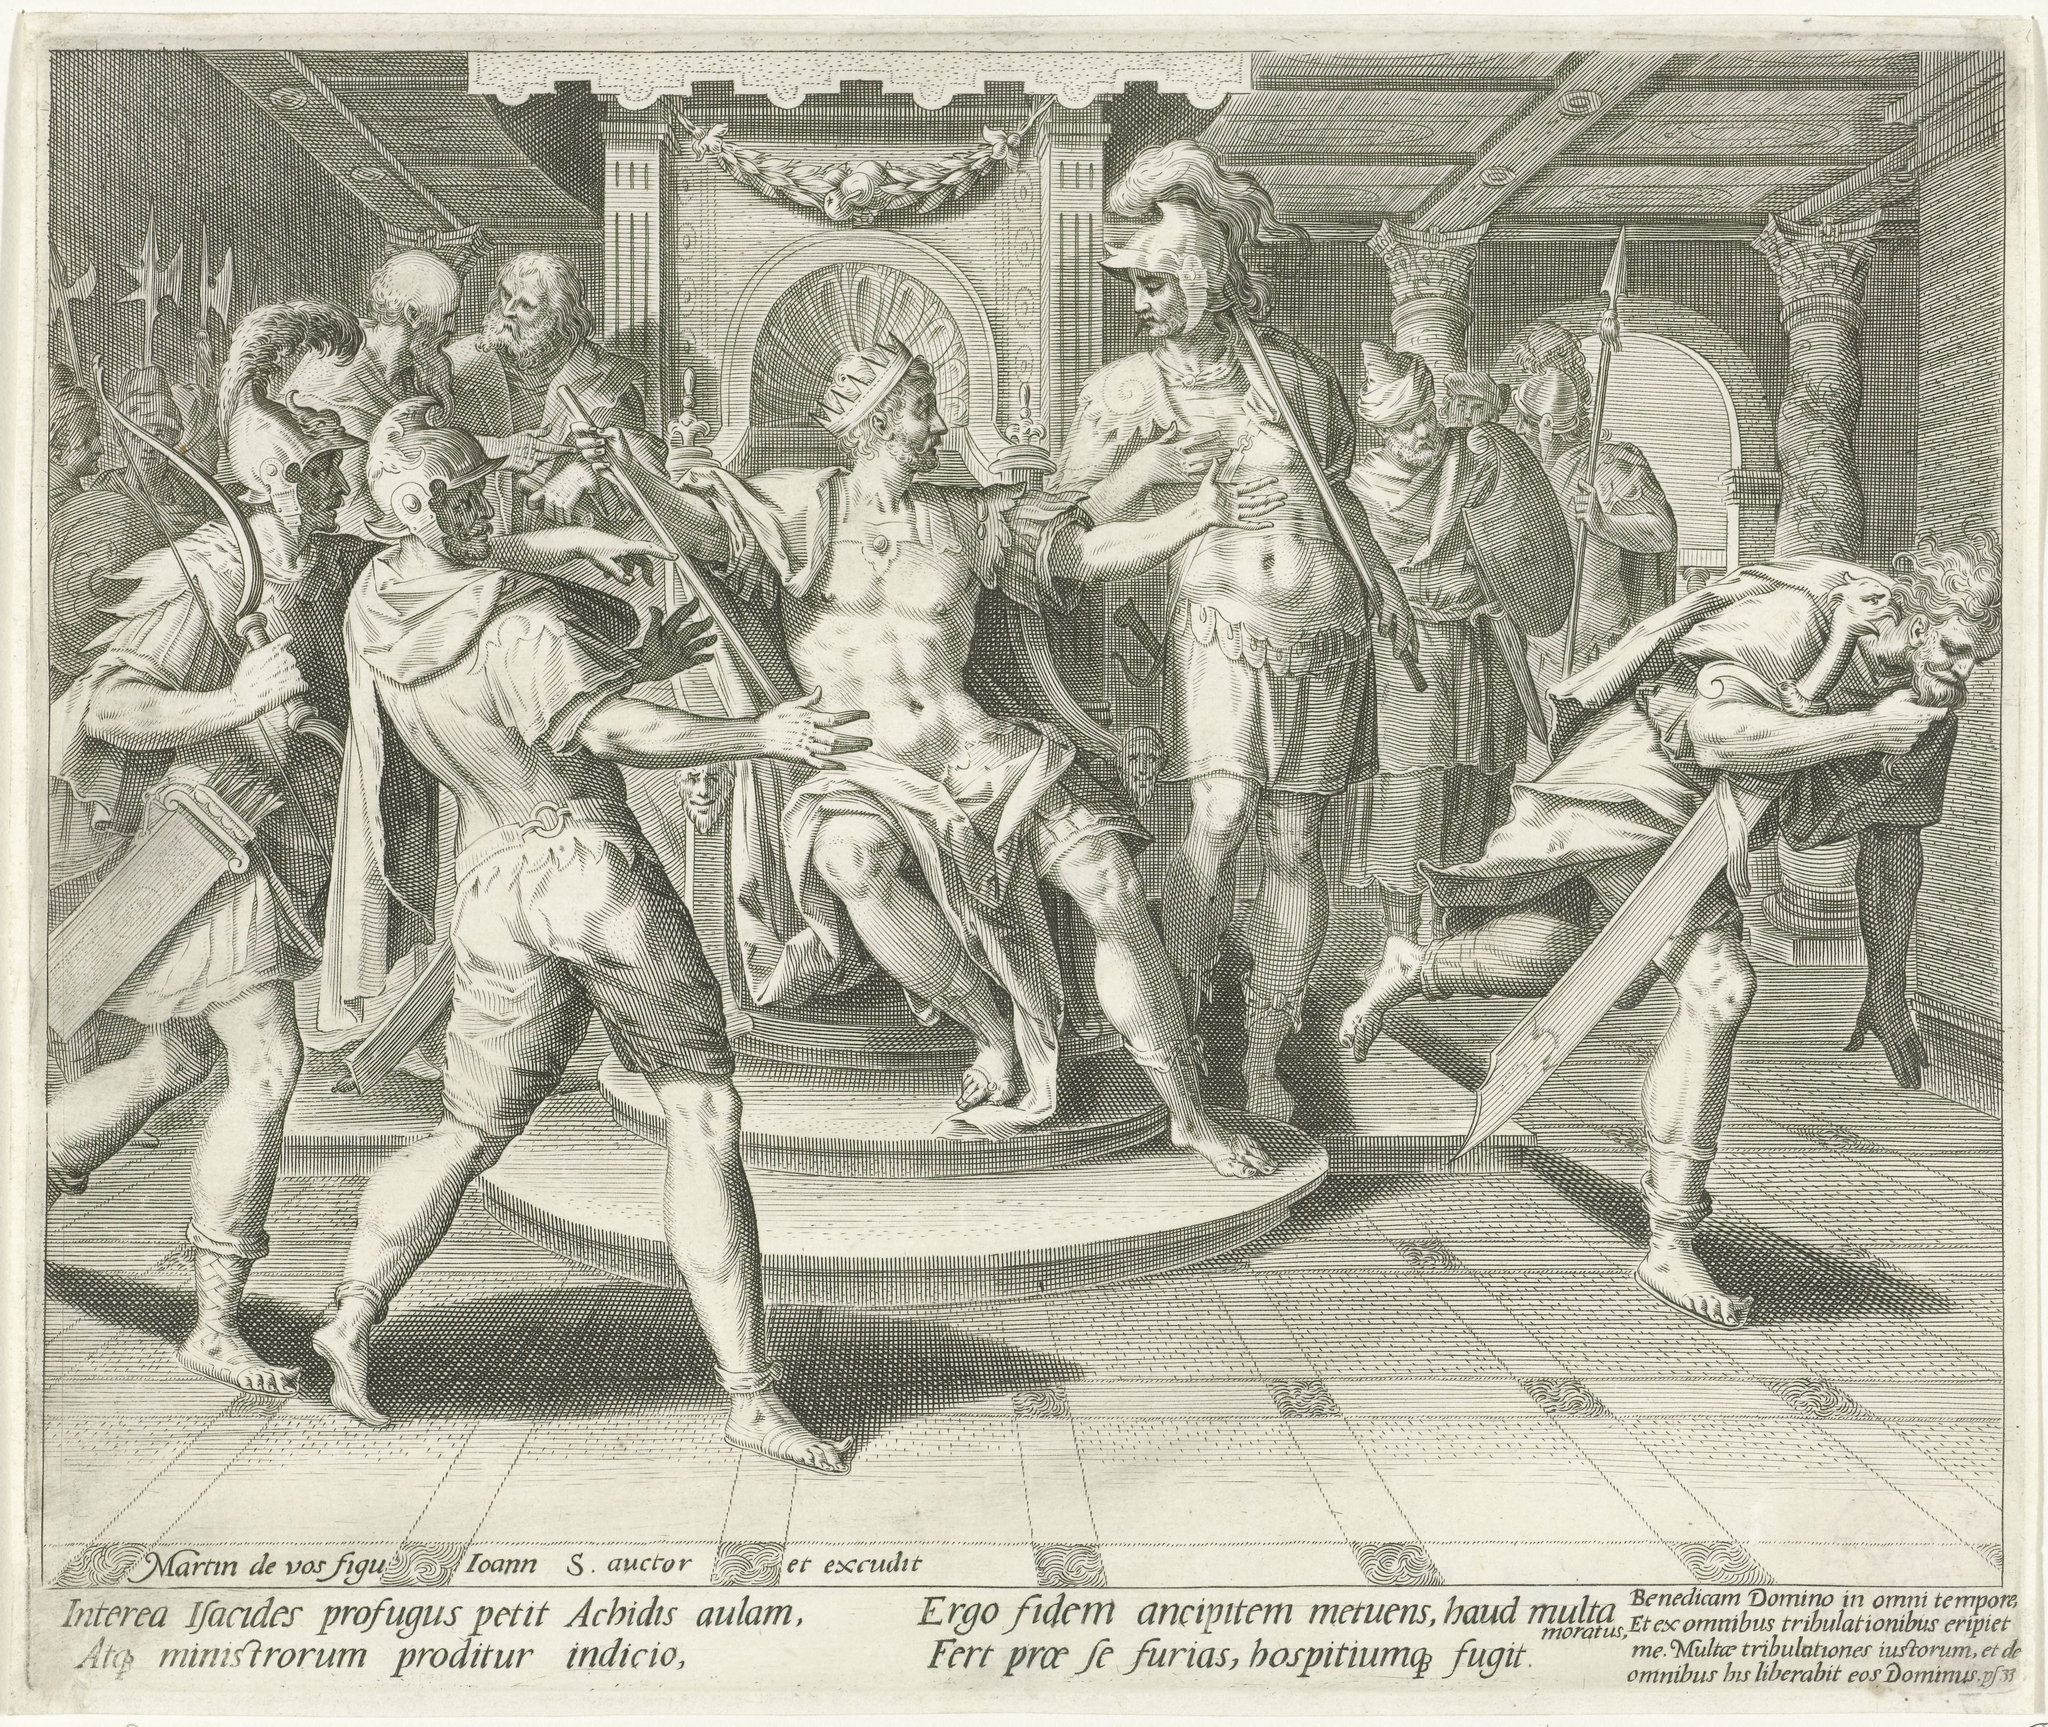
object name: print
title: David simuleert krankzinnigheid voor koning Achis en vlucht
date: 1580-1596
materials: paper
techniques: engraving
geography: antwerp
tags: david sent away by achish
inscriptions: collector's mark: Lugt 240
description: Koning Achis op een troon in zijn paleis, omringd door zijn hovelingen en soldaten. David, rechts, simuleert krankzinnigheid door in zijn baard te kwijlen. Met het zwaard van Goliat ontvlucht hij het paleis. De prent heeft een Latijns onderschrift met uitleg en rechts in de hoek een vers uit psalm 33.